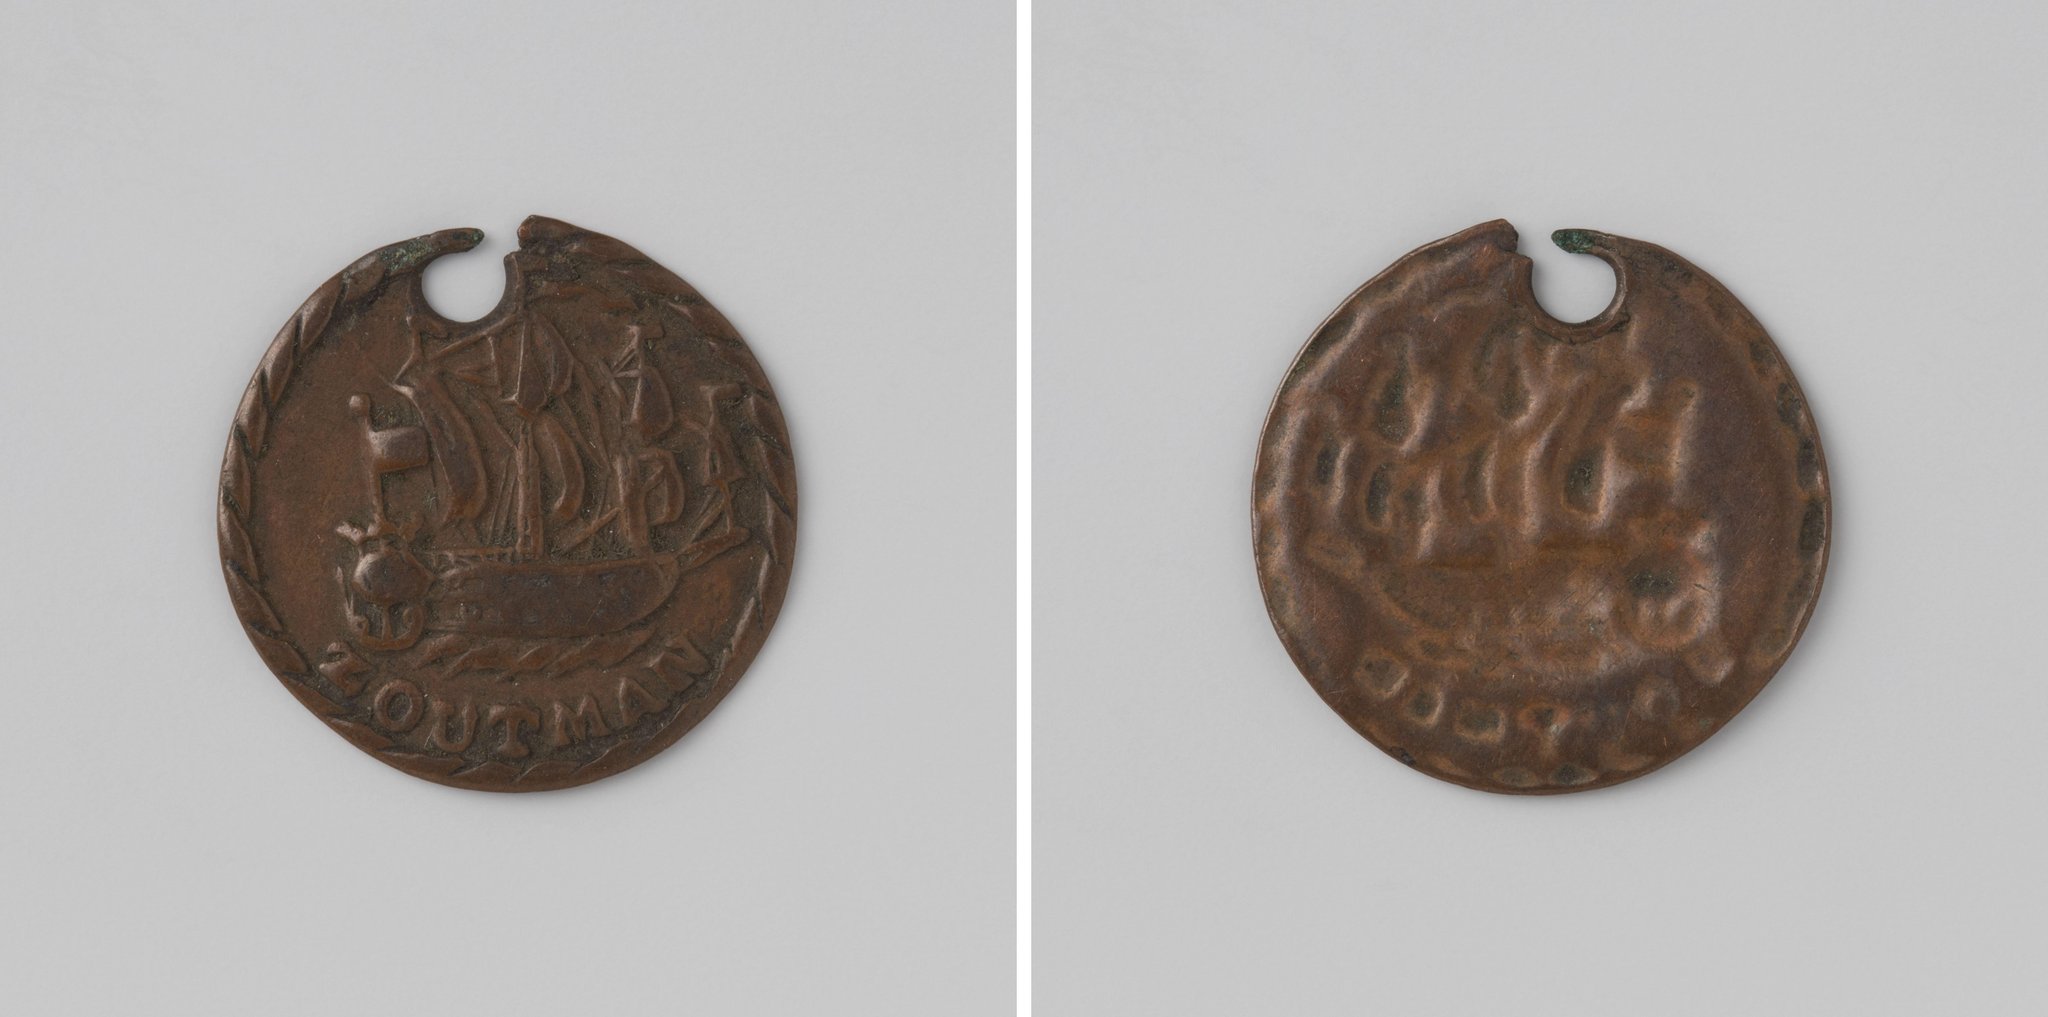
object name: history medal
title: Slag bij Doggersbank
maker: Anonymous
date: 1781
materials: bronze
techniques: striking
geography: netherlands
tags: the hague, johan arnold zoutman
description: Eenzijdige bronzen penning met gat erin. Voorzijde: schip boven opschrift binnen kabelrand. Keerzijde: blanco